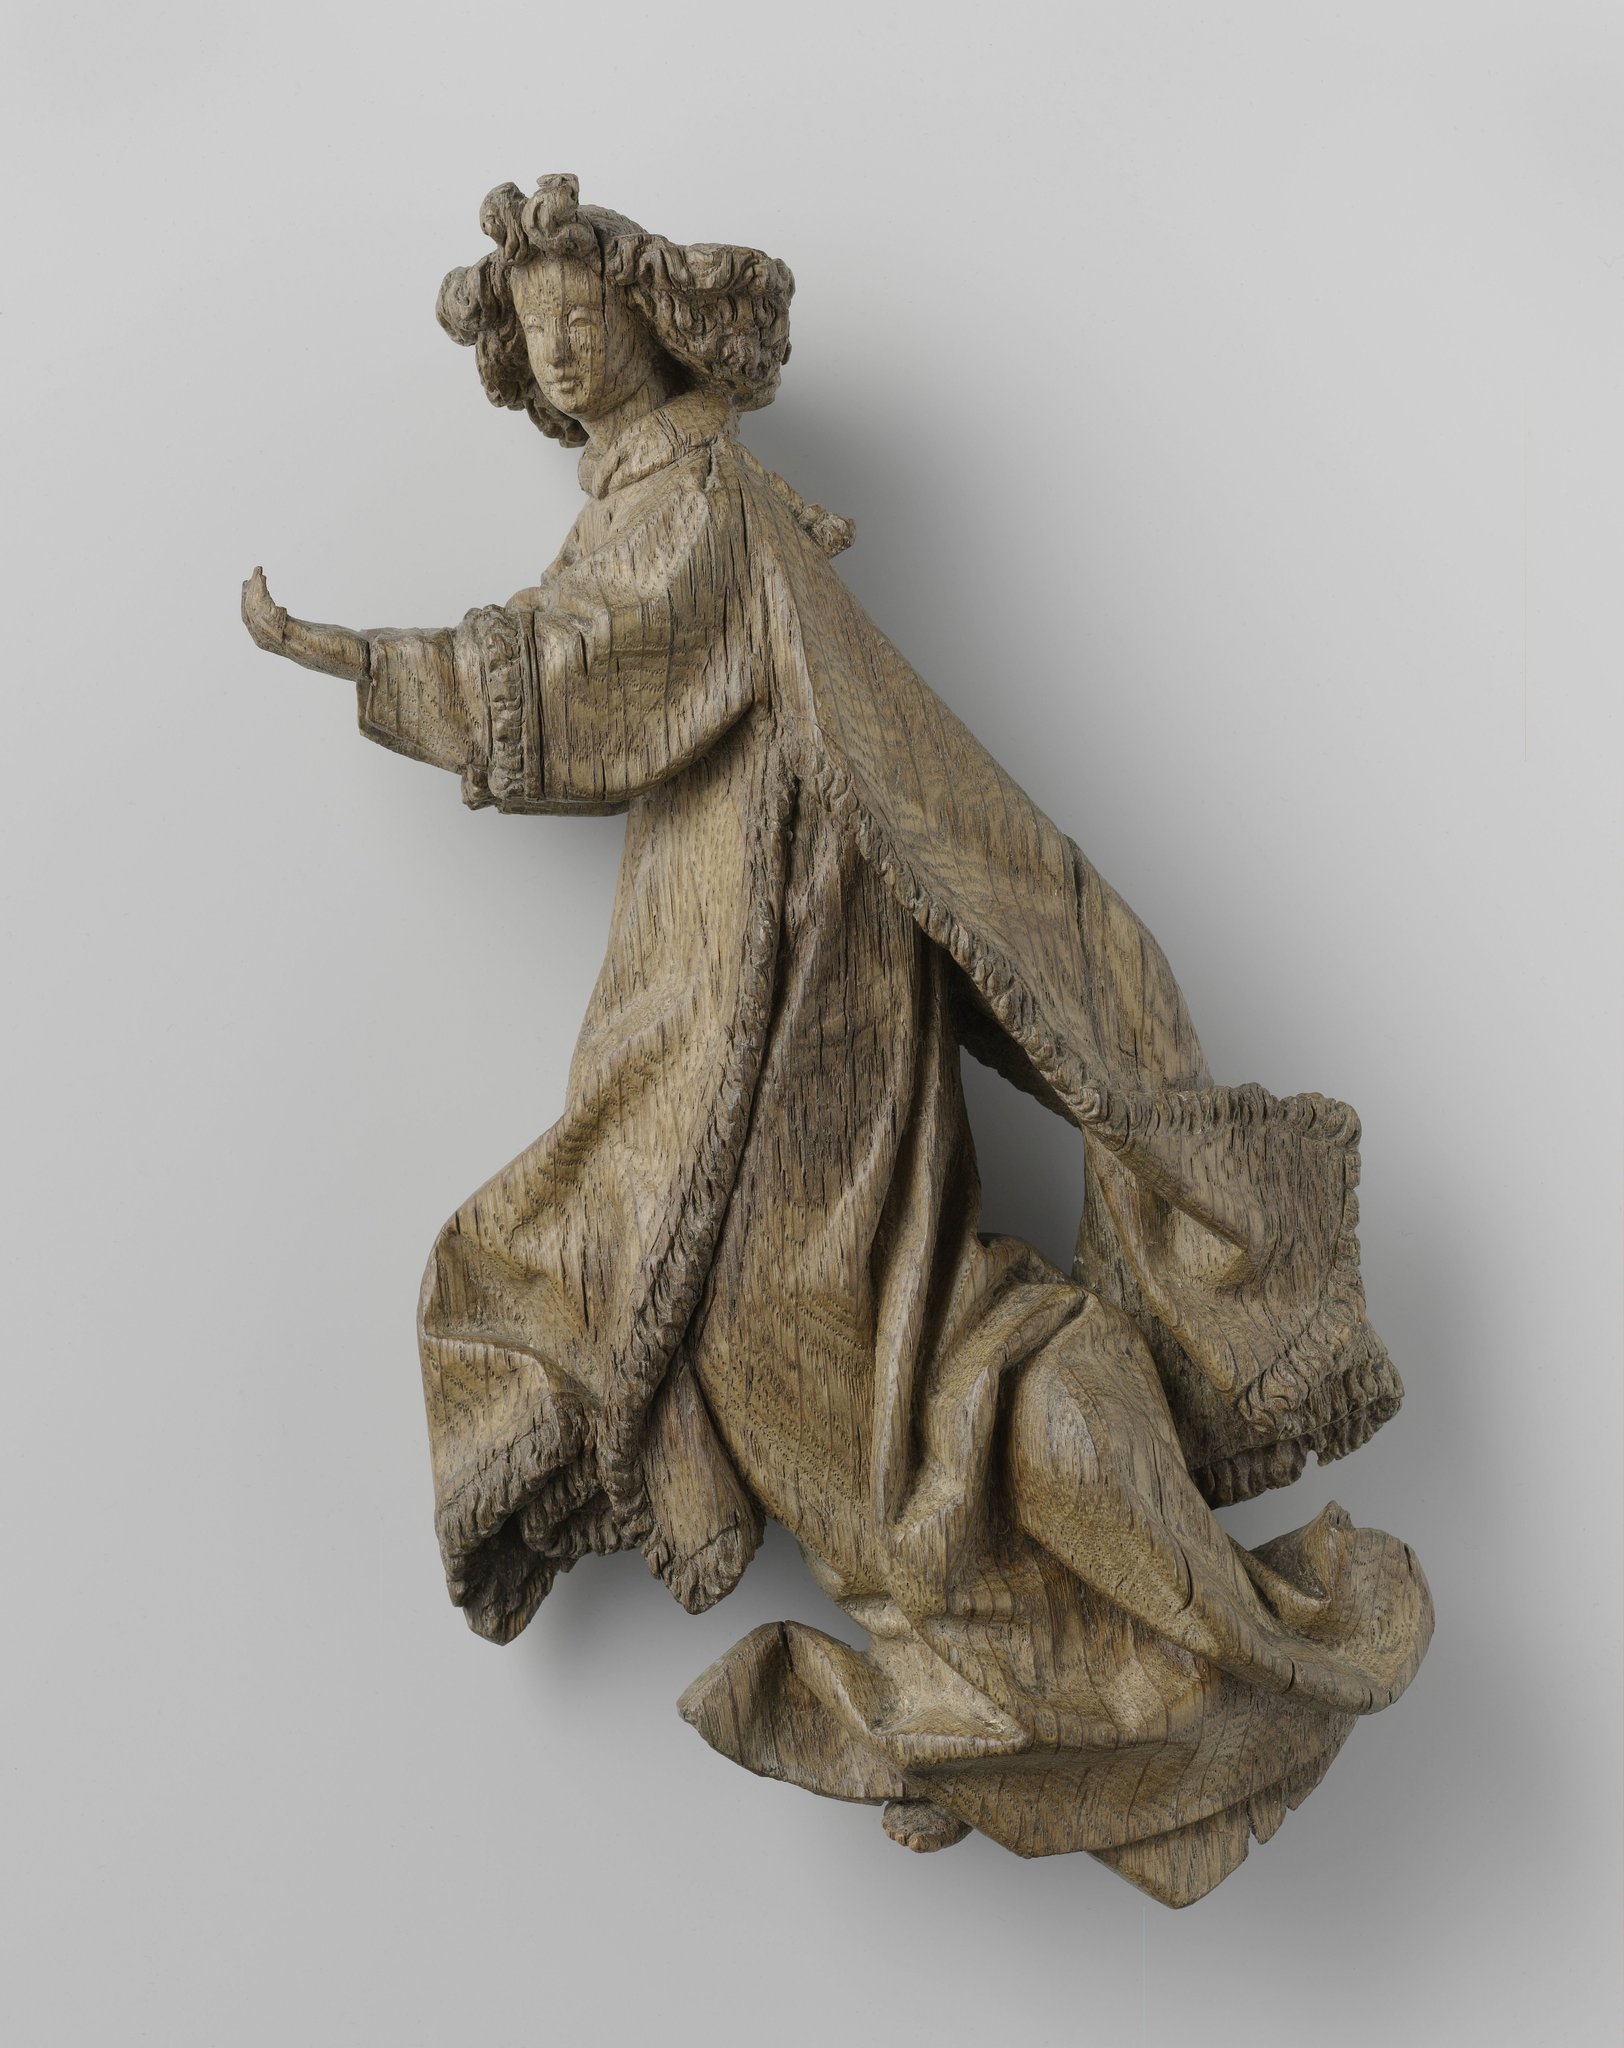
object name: sculpture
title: Hovering Angel, from a Calvary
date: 1490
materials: wood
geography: brussels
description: Twee zwevende engelen. Eikenhout, ontdaan van polychromie. Brussel, ca. 1490.